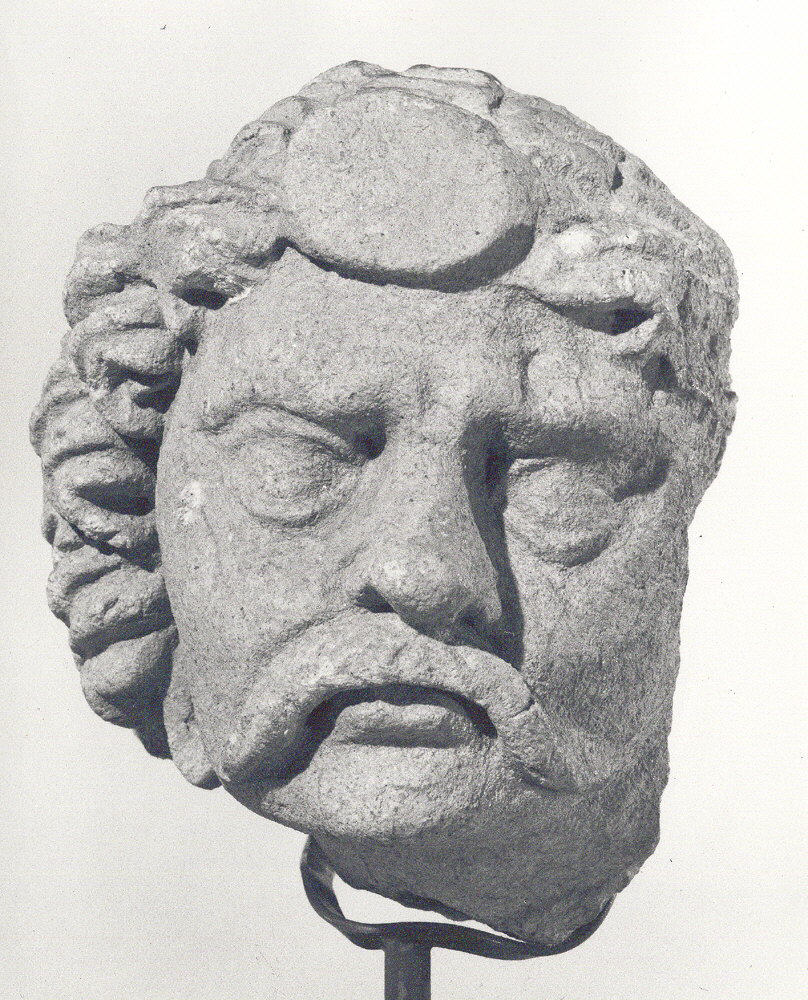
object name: head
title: Head of a Male Figure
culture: afghan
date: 401-500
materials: plaster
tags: gandharan,heads,men